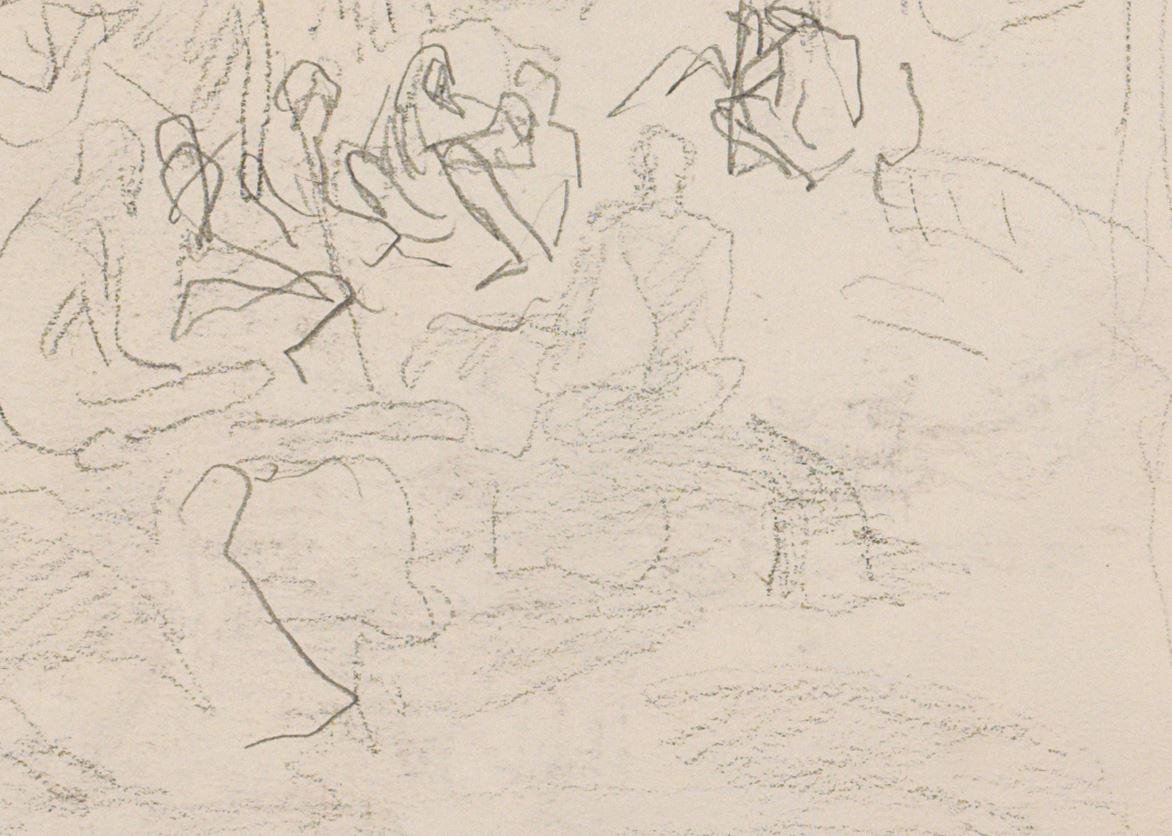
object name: sketchbook leaf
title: Indiërs zittend onder een parasol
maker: marius bauer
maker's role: draughtsman, print maker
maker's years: 1867-1932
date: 1924-1925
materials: chalk, paper, pencil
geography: india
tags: sitting figure, asiatic races and peoples: indians, parasol, sunshade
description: De figuren zitten op kleden, vermoedelijk aan de oever van de Ganges. Pagina 22 uit een schetsboek met 23 bladen.